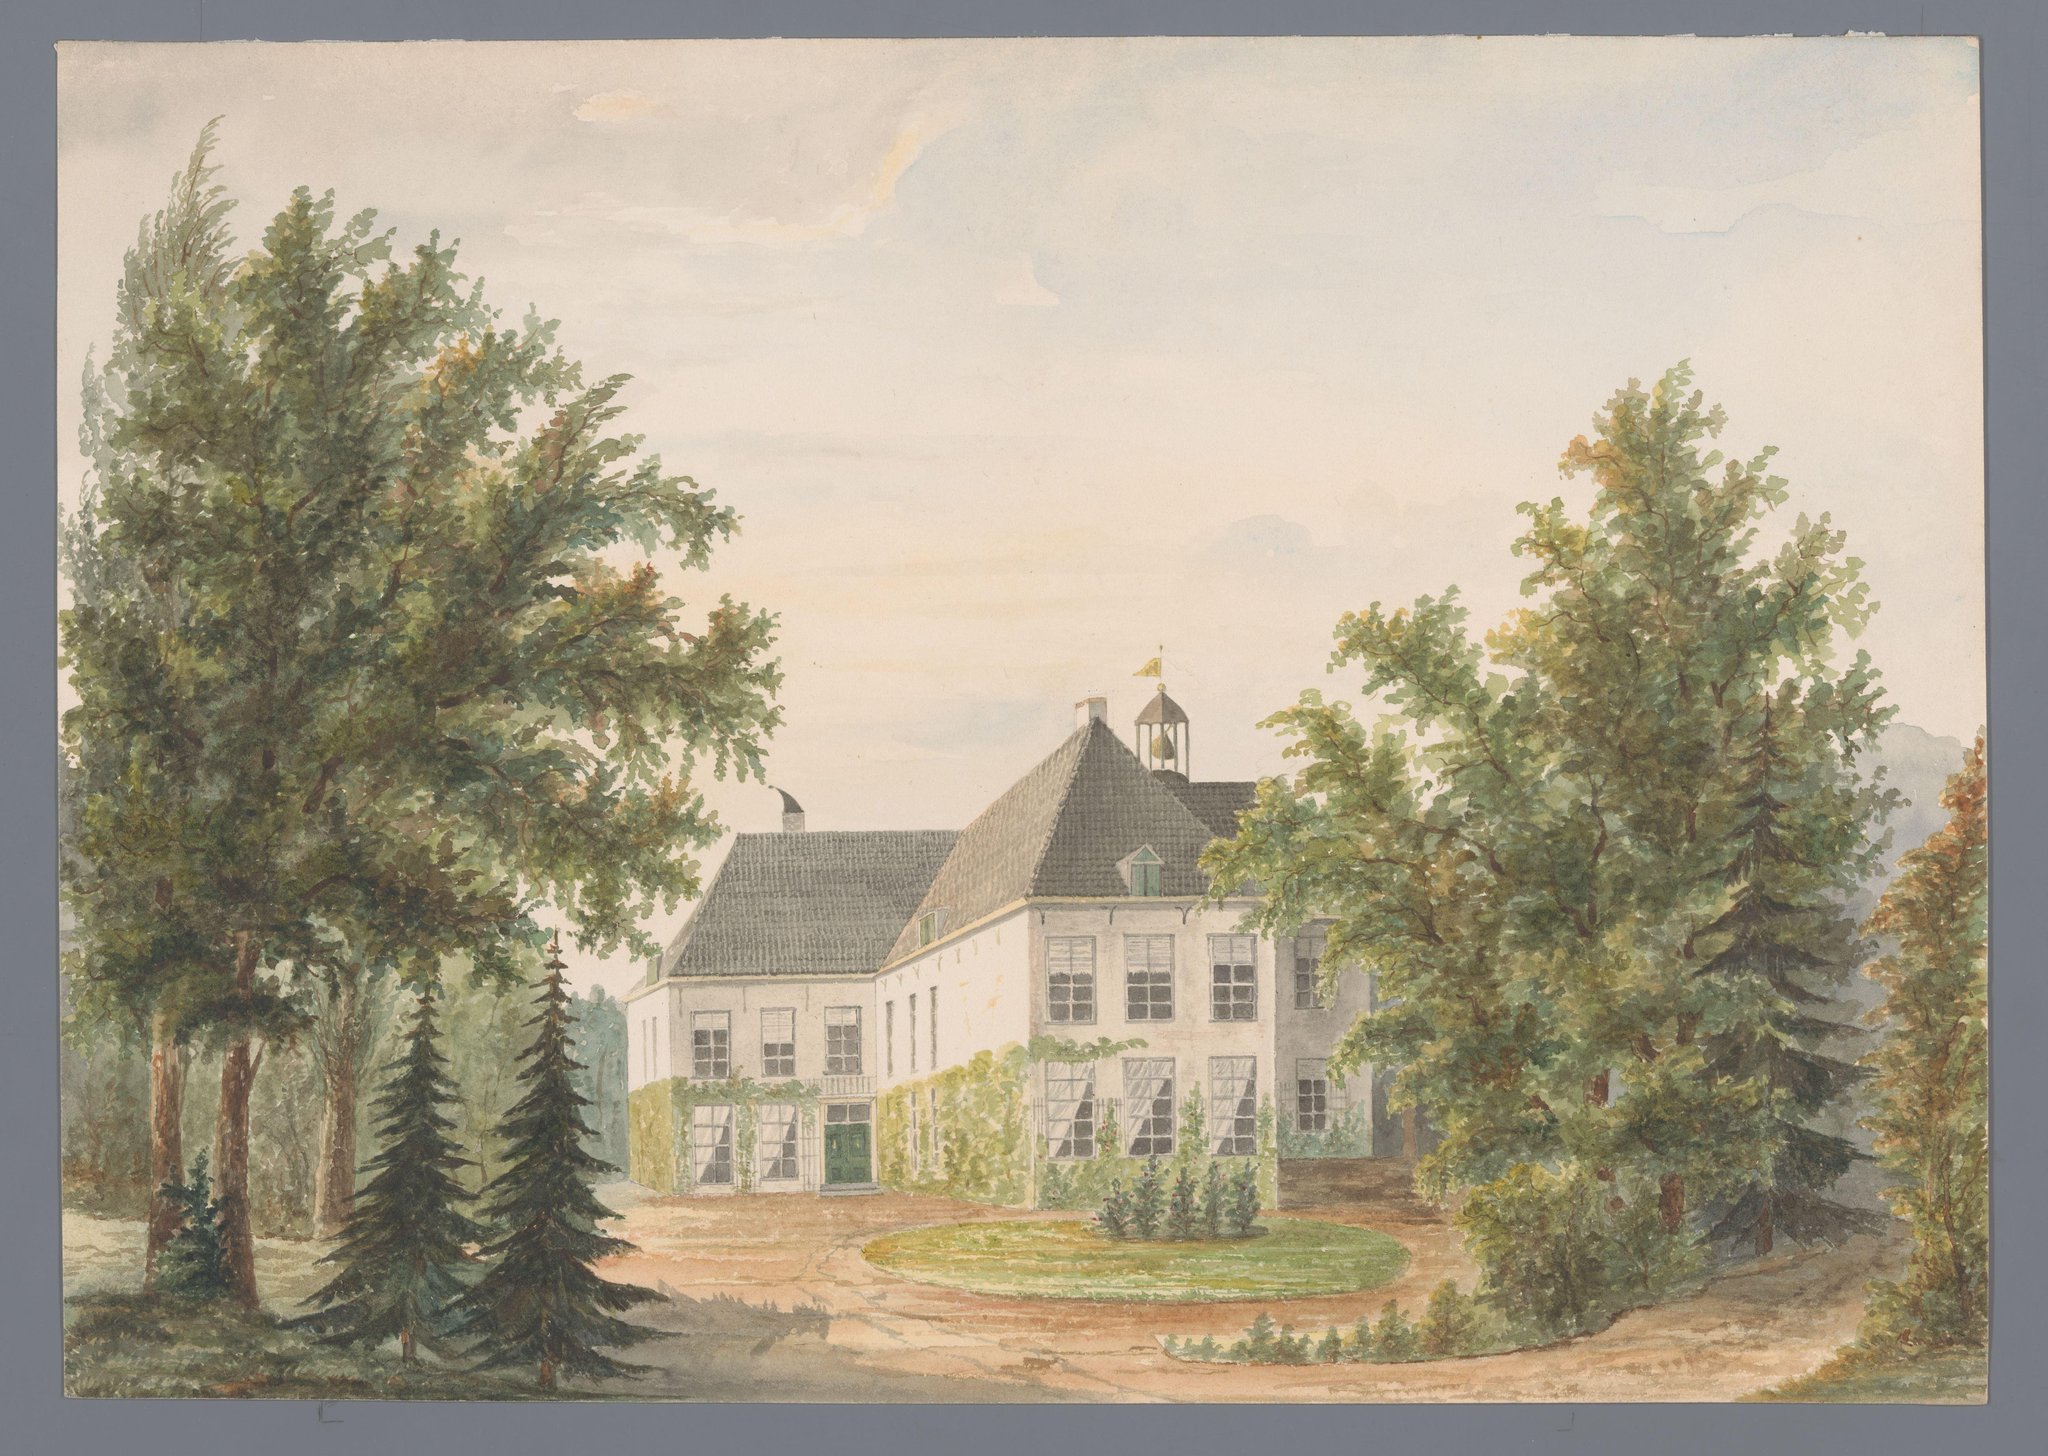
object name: costume print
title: Twee mannen gekleed volgens de Franse mode van ca. 1696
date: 1690-1700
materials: paper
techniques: etching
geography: paris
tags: head-gear: tricorn (+ men's clothes), styles of hairdress (allonge), coat (justaucorps) (+ men's clothes), head-gear: hat (+ men's clothes), hacking and thrusting weapons: sword, shoes, sandals (+ men's clothes), clothes, costume (+ men's clothes), stockings, socks (+ men's clothes)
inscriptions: address: ‘A Paris chez I. Mariette rue St. Iacques...aux colonnes d; Hercules avec Priv. du Roy’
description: Links: Man met sierdegen aan de linkerzijde. Rechts: man leunend tegen balustrade.